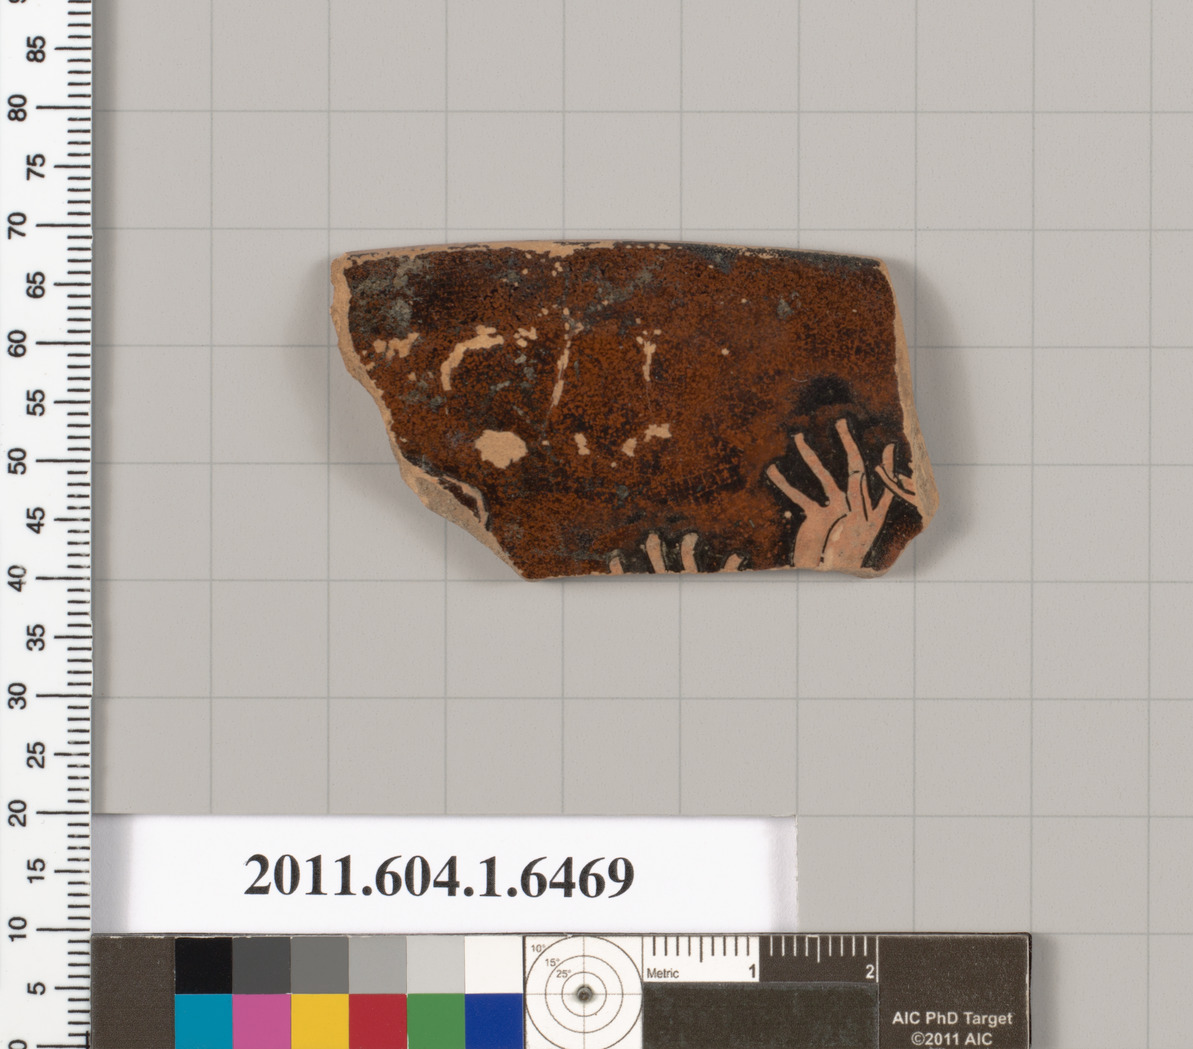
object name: kylix fragment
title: Terracotta rim fragment of a kylix (drinking cup)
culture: greek, attic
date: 490-480 BCE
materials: terracotta